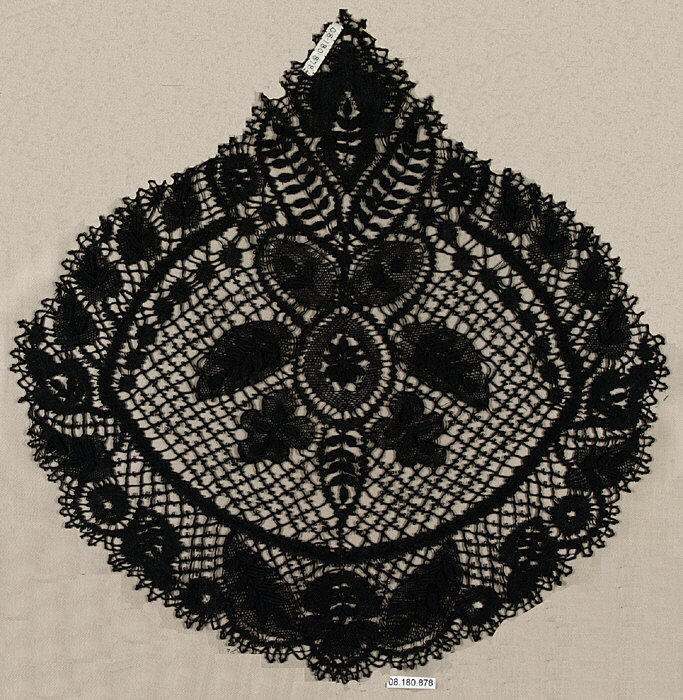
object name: cap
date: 1801-1900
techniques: lace